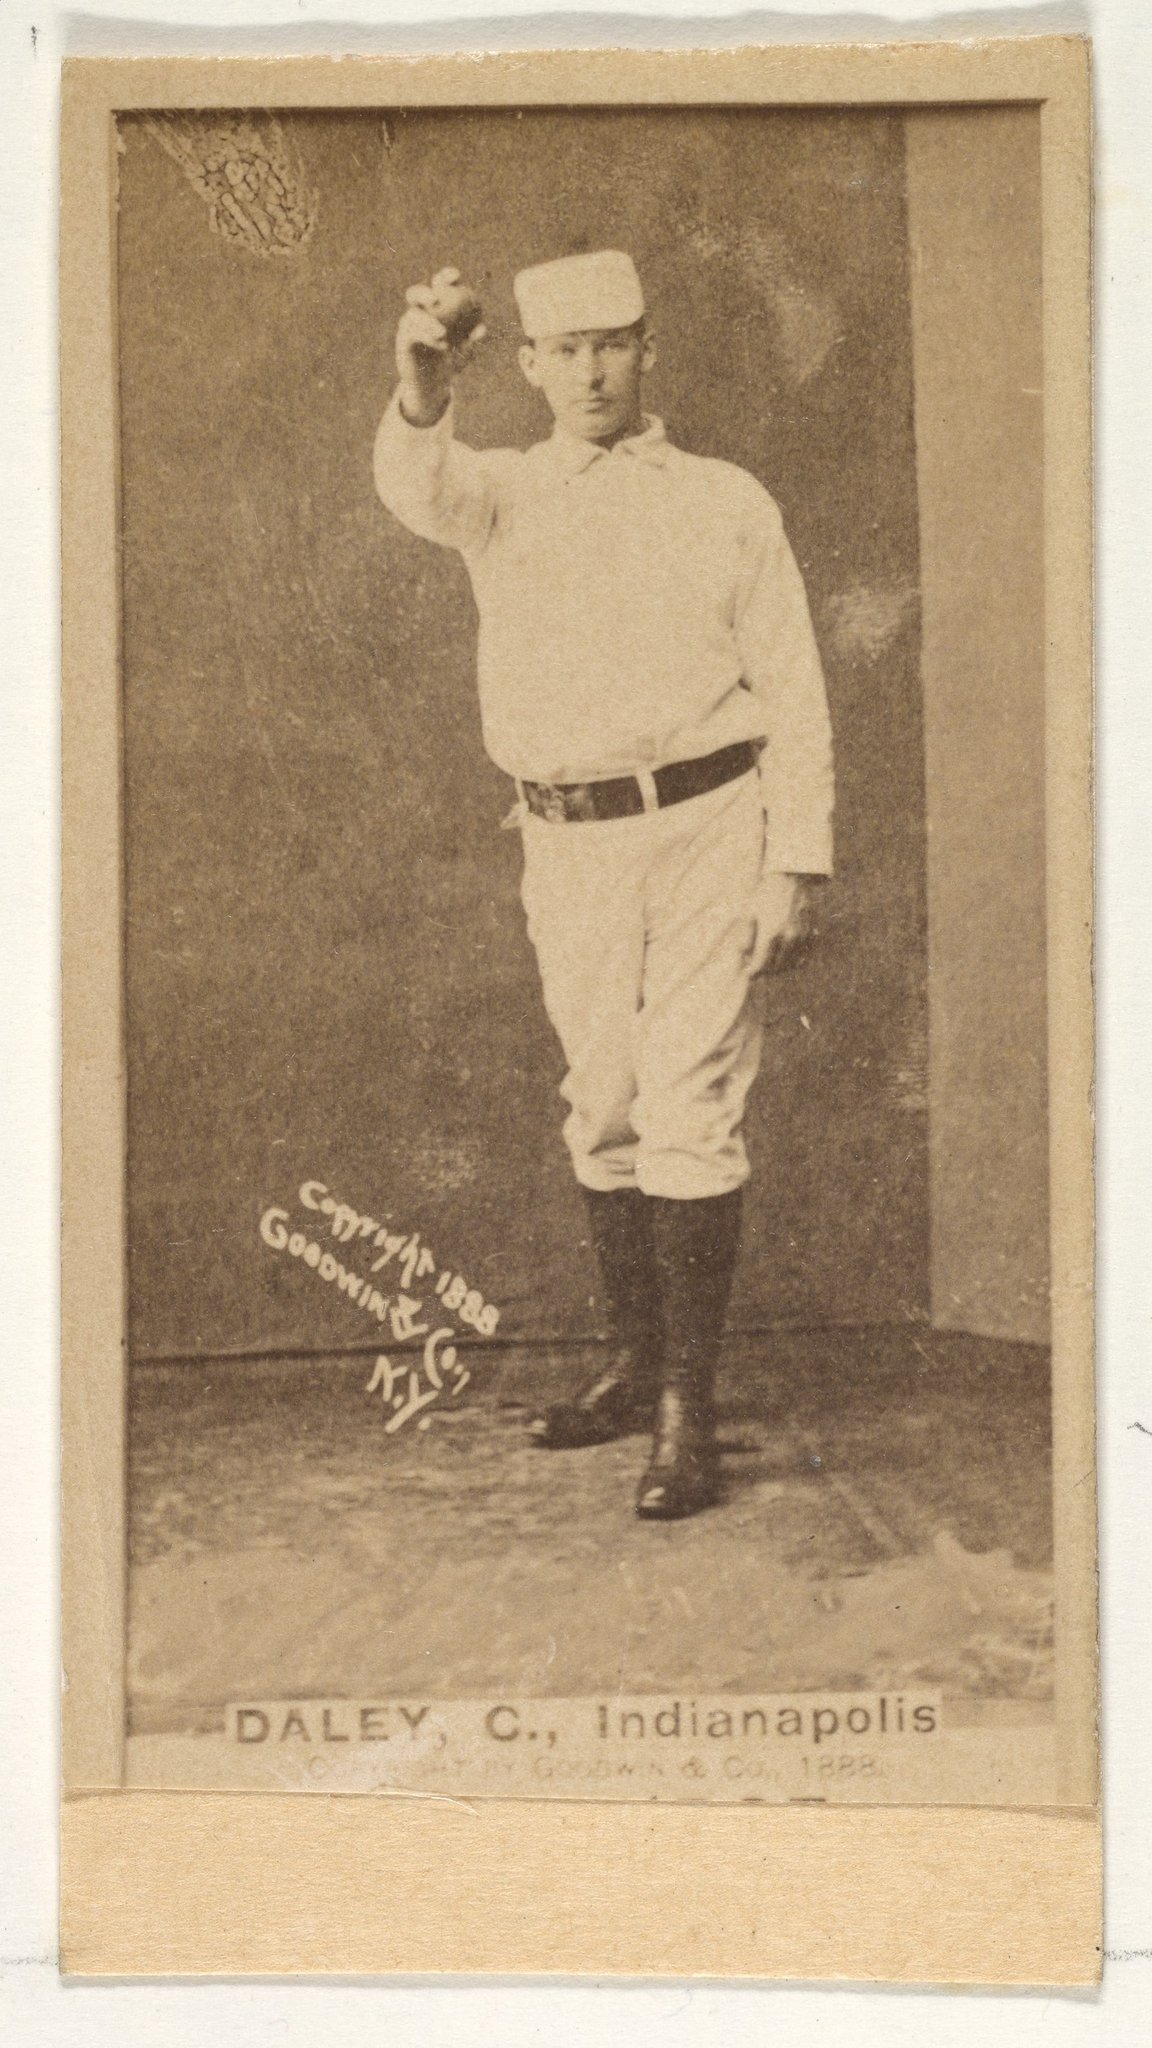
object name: baseball card, photograph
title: Daley, Catcher, Indianapolis, from the Old Judge series (N172) for Old Judge Cigarettes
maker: goodwin & company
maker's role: publisher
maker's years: 1850-1950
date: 1888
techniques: albumen silver print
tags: men,portraits,baseball,athletes